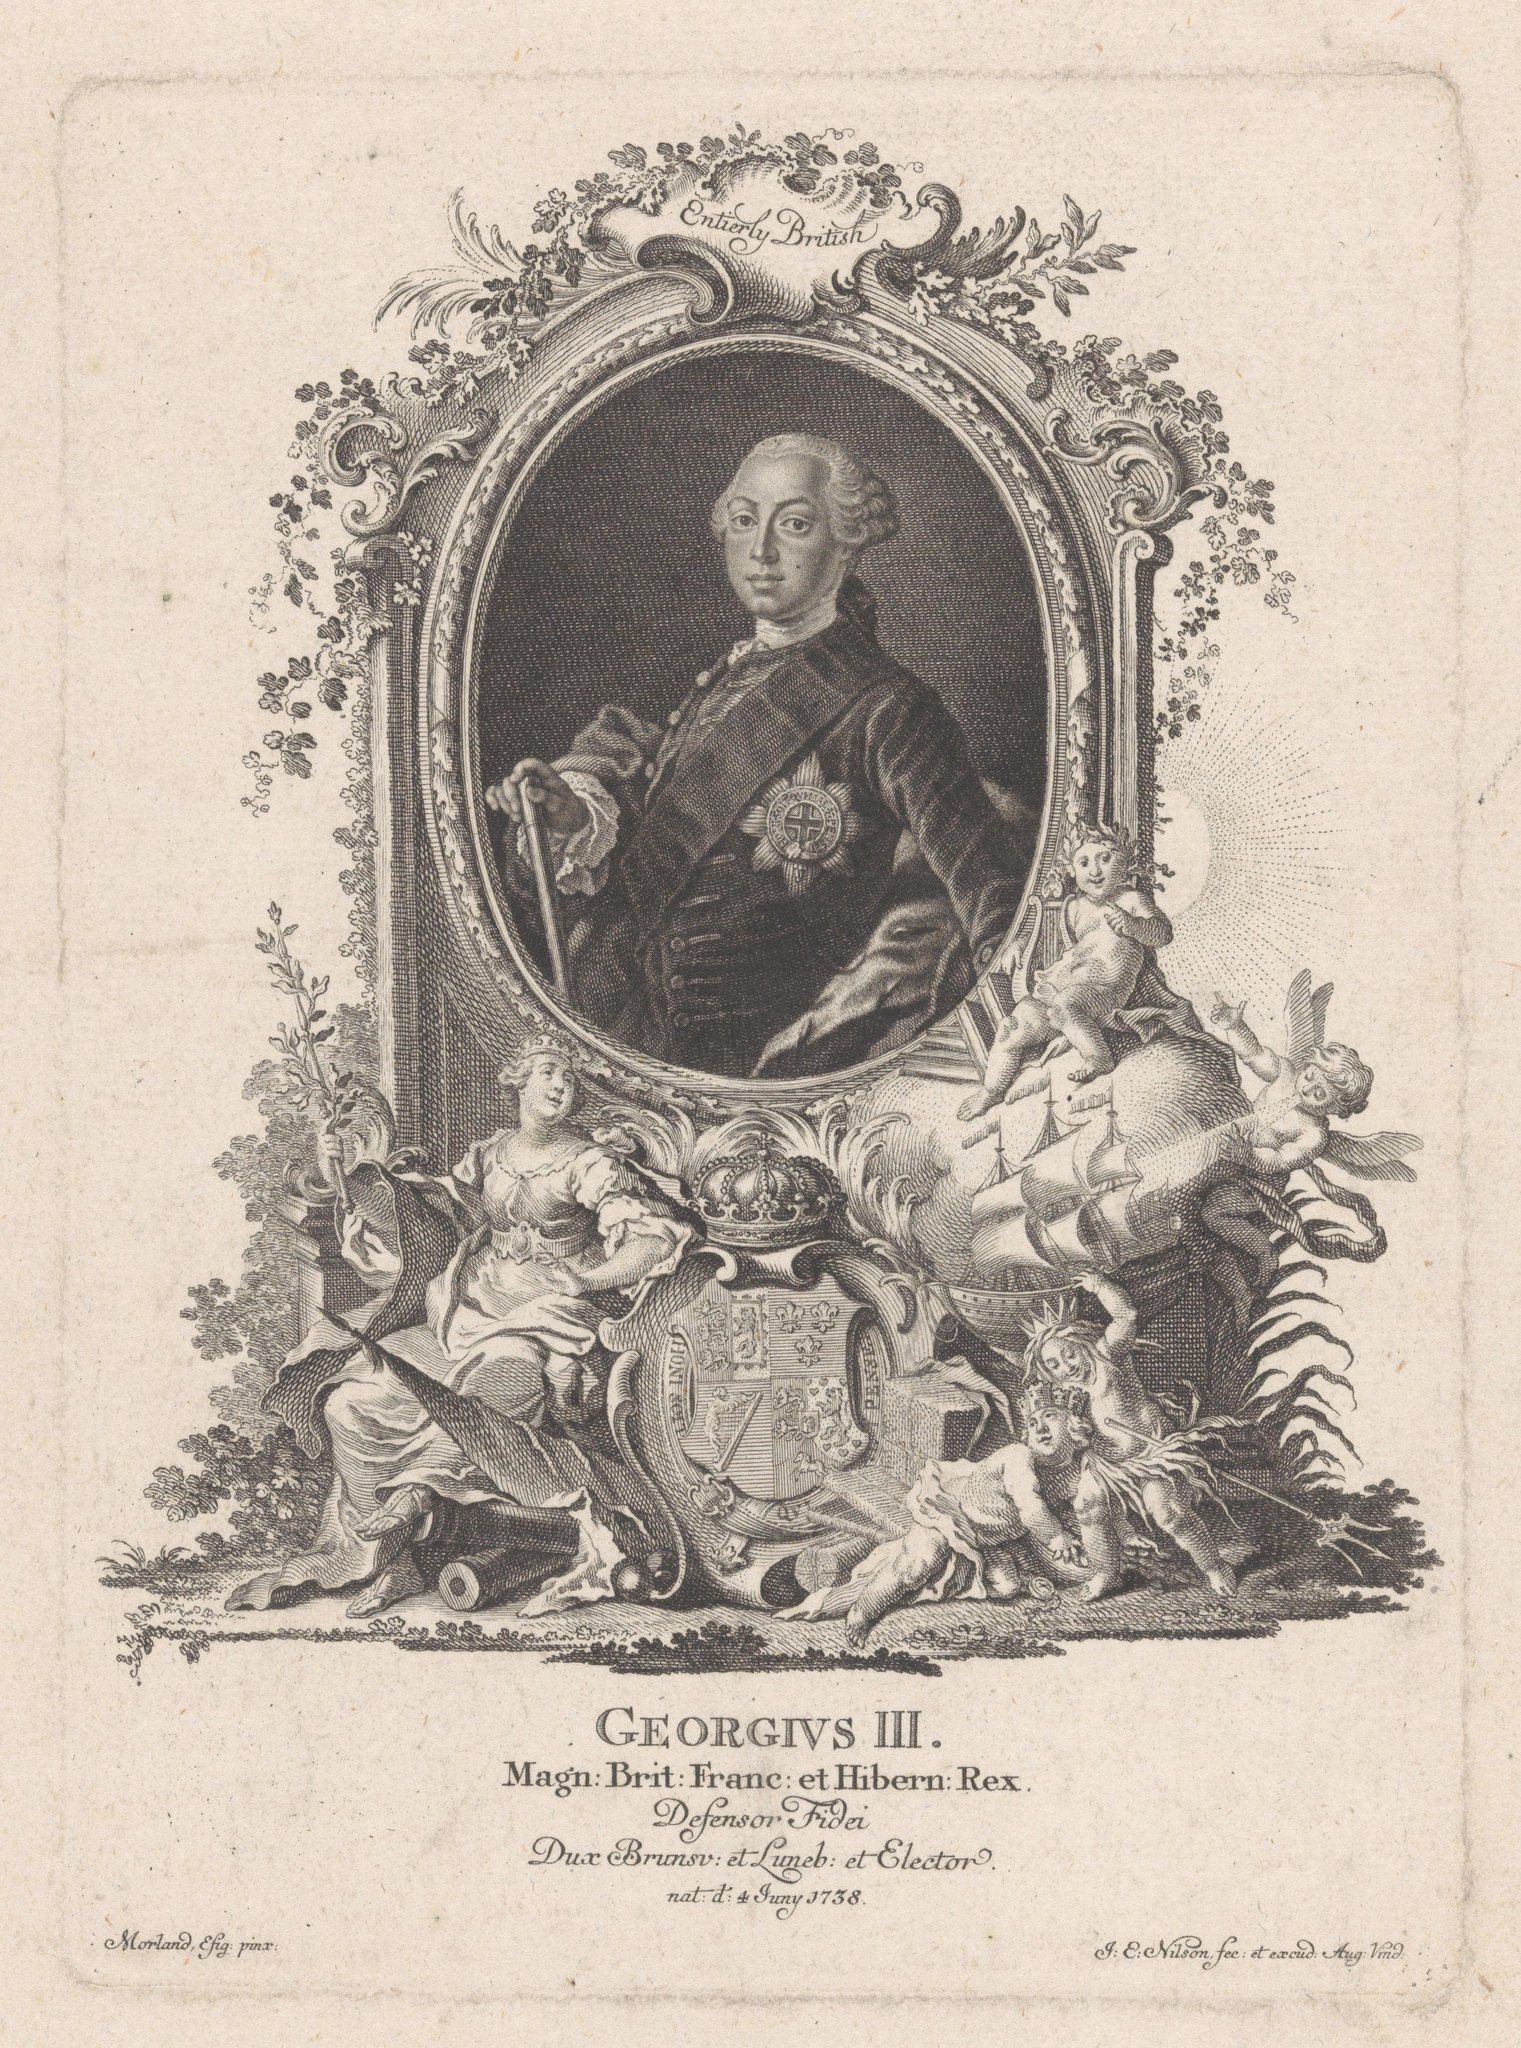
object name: ornament print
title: Portret van George III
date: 1760-1788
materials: paper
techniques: engraving, etching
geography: augsburg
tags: london, george iii (koning van het verenigd koninkrijk), historical persons, cupids: 'amores', 'amoretti', 'putti', king, armorial bearing, heraldry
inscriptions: collector's mark: Lugt 2228, collector's mark: Lugt 2760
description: Portret van George III, koning van Groot-Brittannië en Ierland, op jonge leeftijd in ovale omlijsting met cartouche met text Entierly British. Onder de omlijsting een wapenschild in bekroond cartouche. Links zit een gekroonde vrouw met een laurier omwonden scepter. Rechts spelen vier putti verkleed als goden.